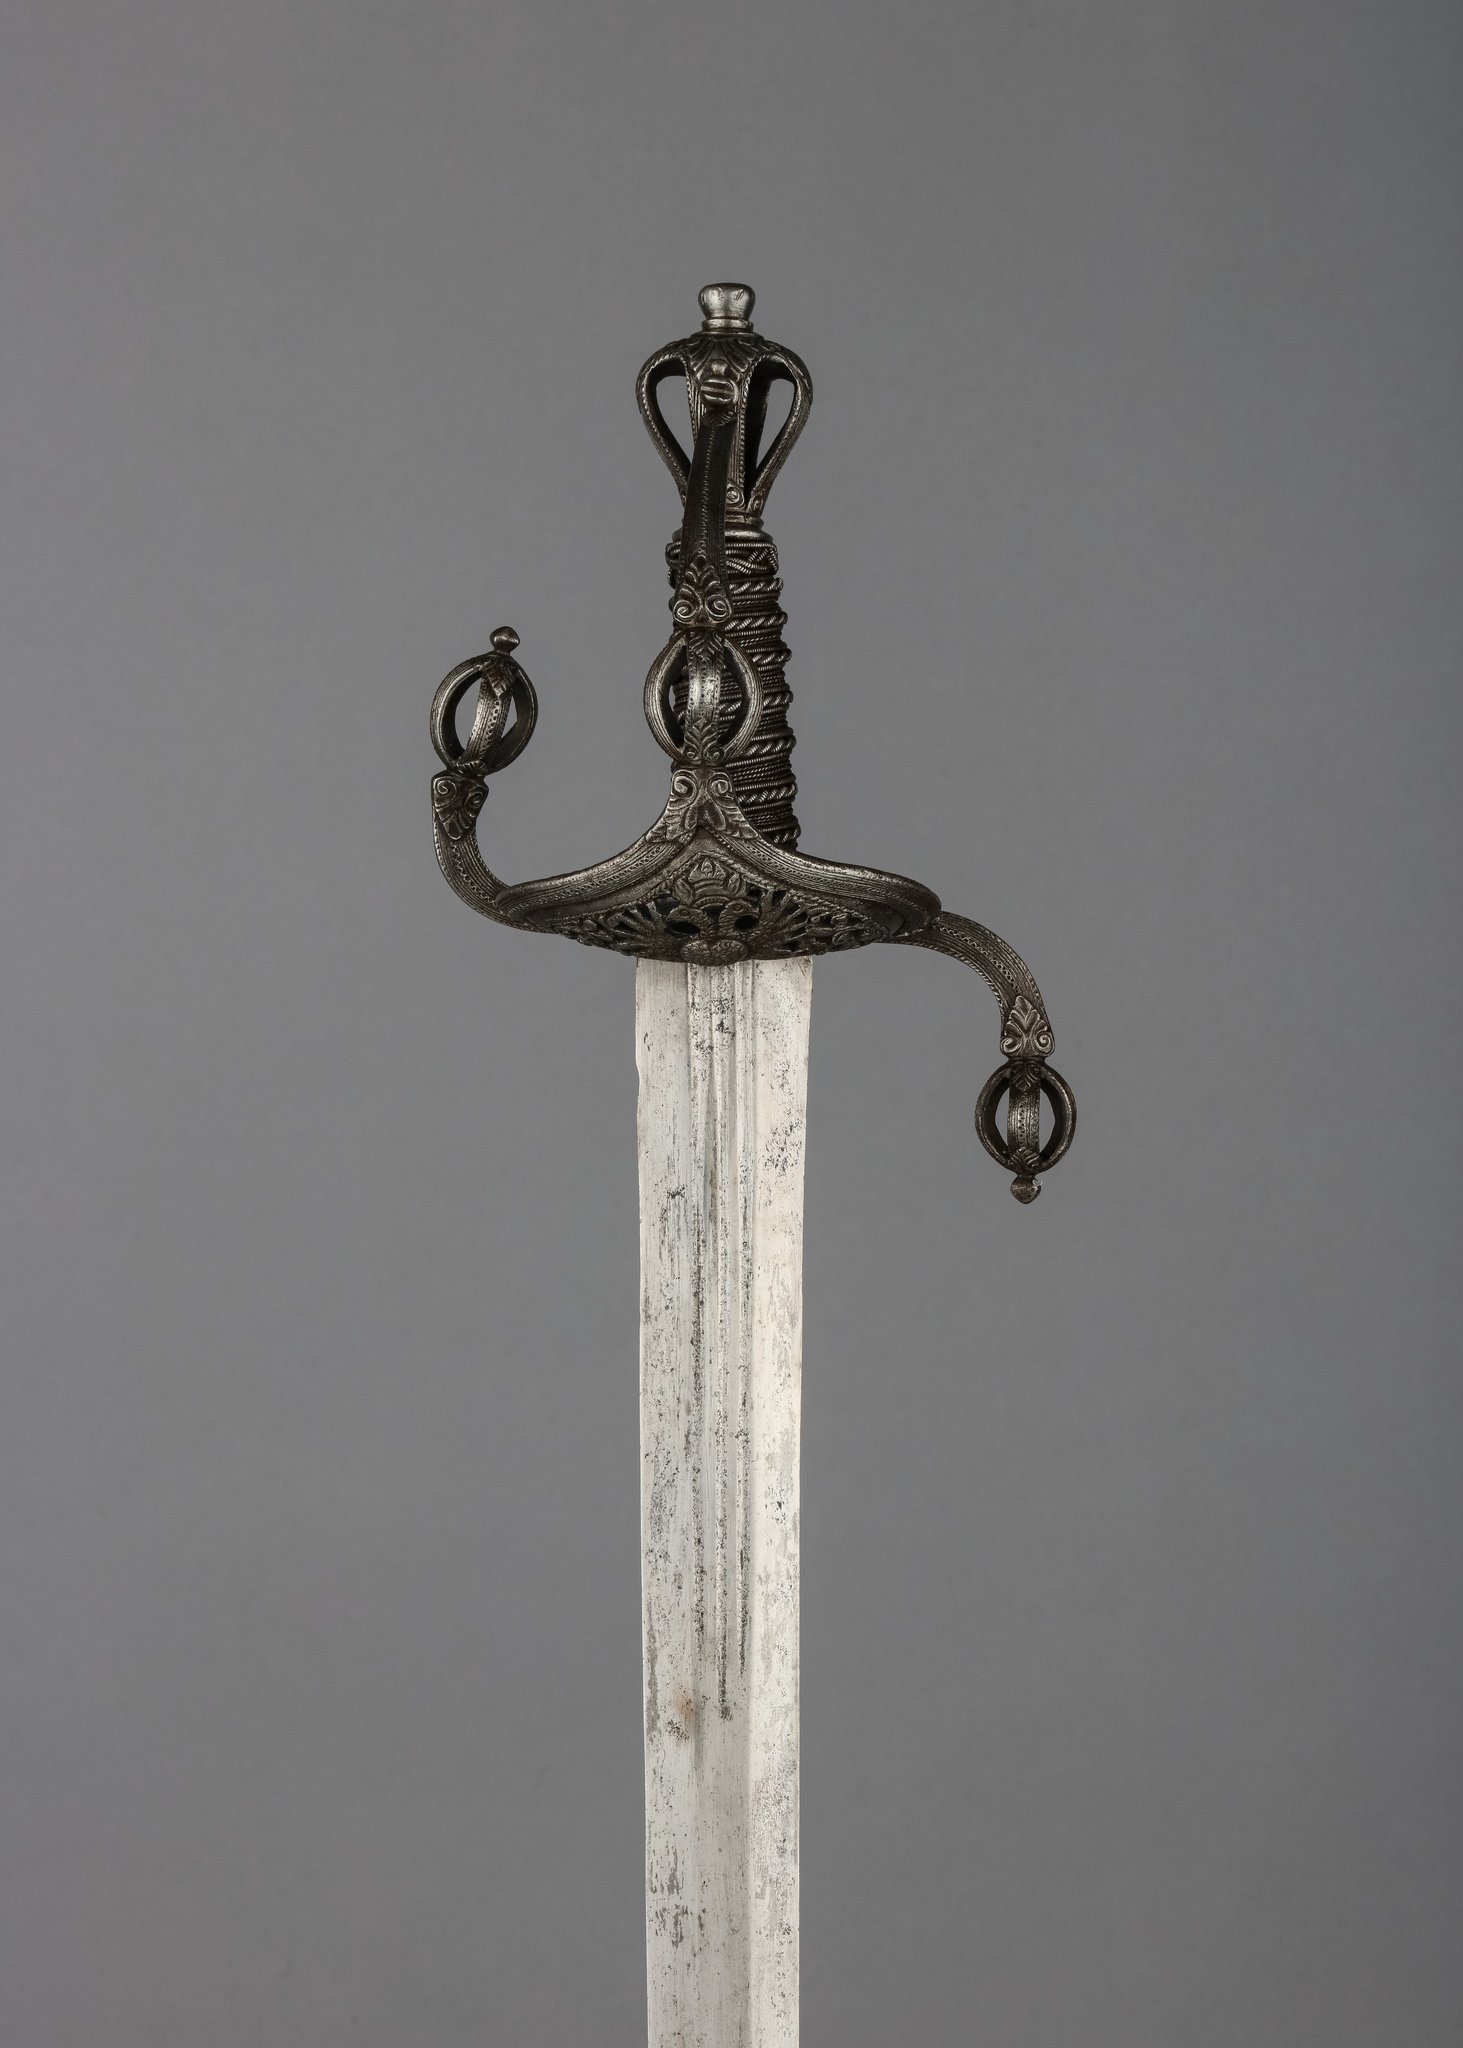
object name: sword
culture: german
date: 1620-1640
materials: steel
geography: germany